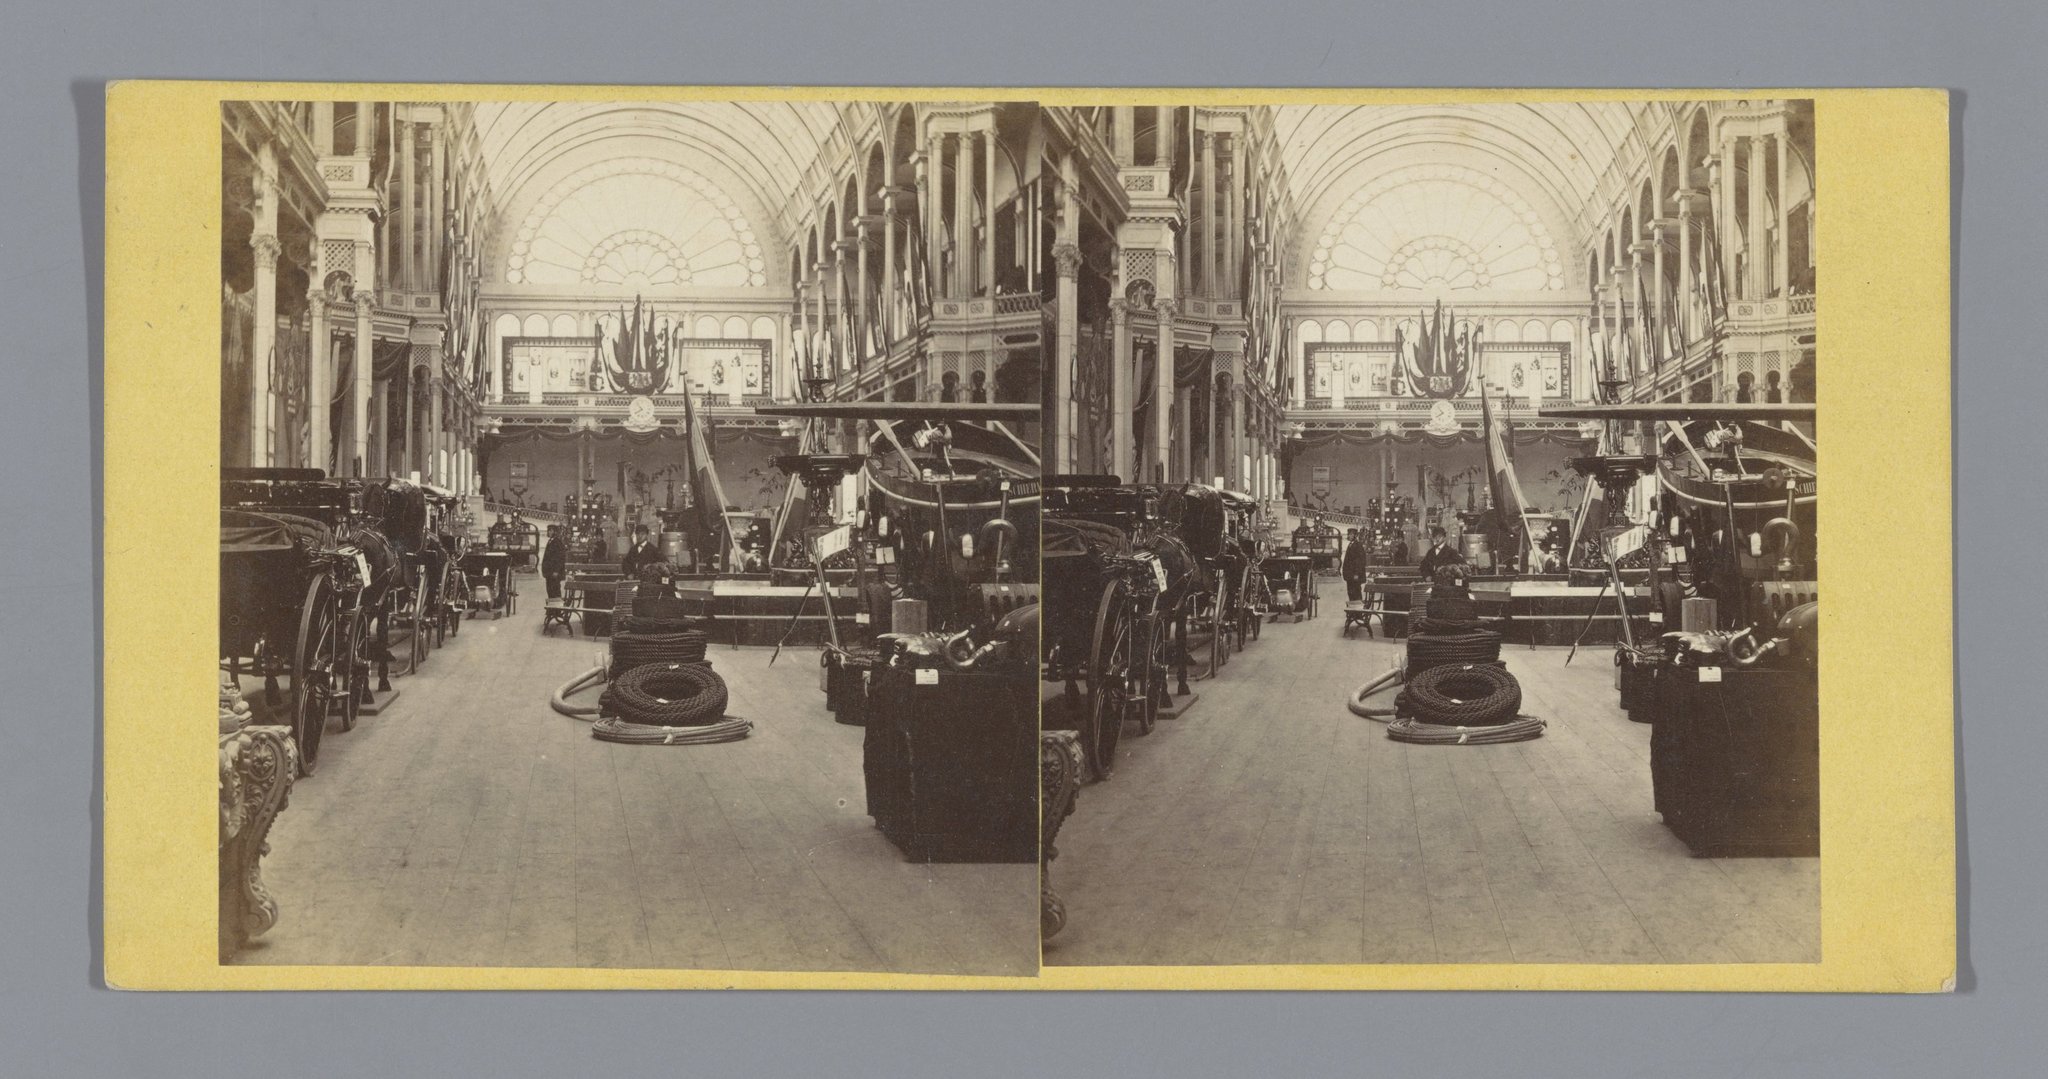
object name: stereograph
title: Tentoonstelling in het Paleis voor Volksvlijt, Amsterdam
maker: Anonymous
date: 1864-1890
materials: cardboard, paper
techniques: albumen print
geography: amsterdam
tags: collection, exhibition, show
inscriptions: retailer's mark: ‘Boek- & papierhandel/ T. Kouwenaar/ Amsterdam/ Kalverstraat E 27.’, monogram: ‘LDB’